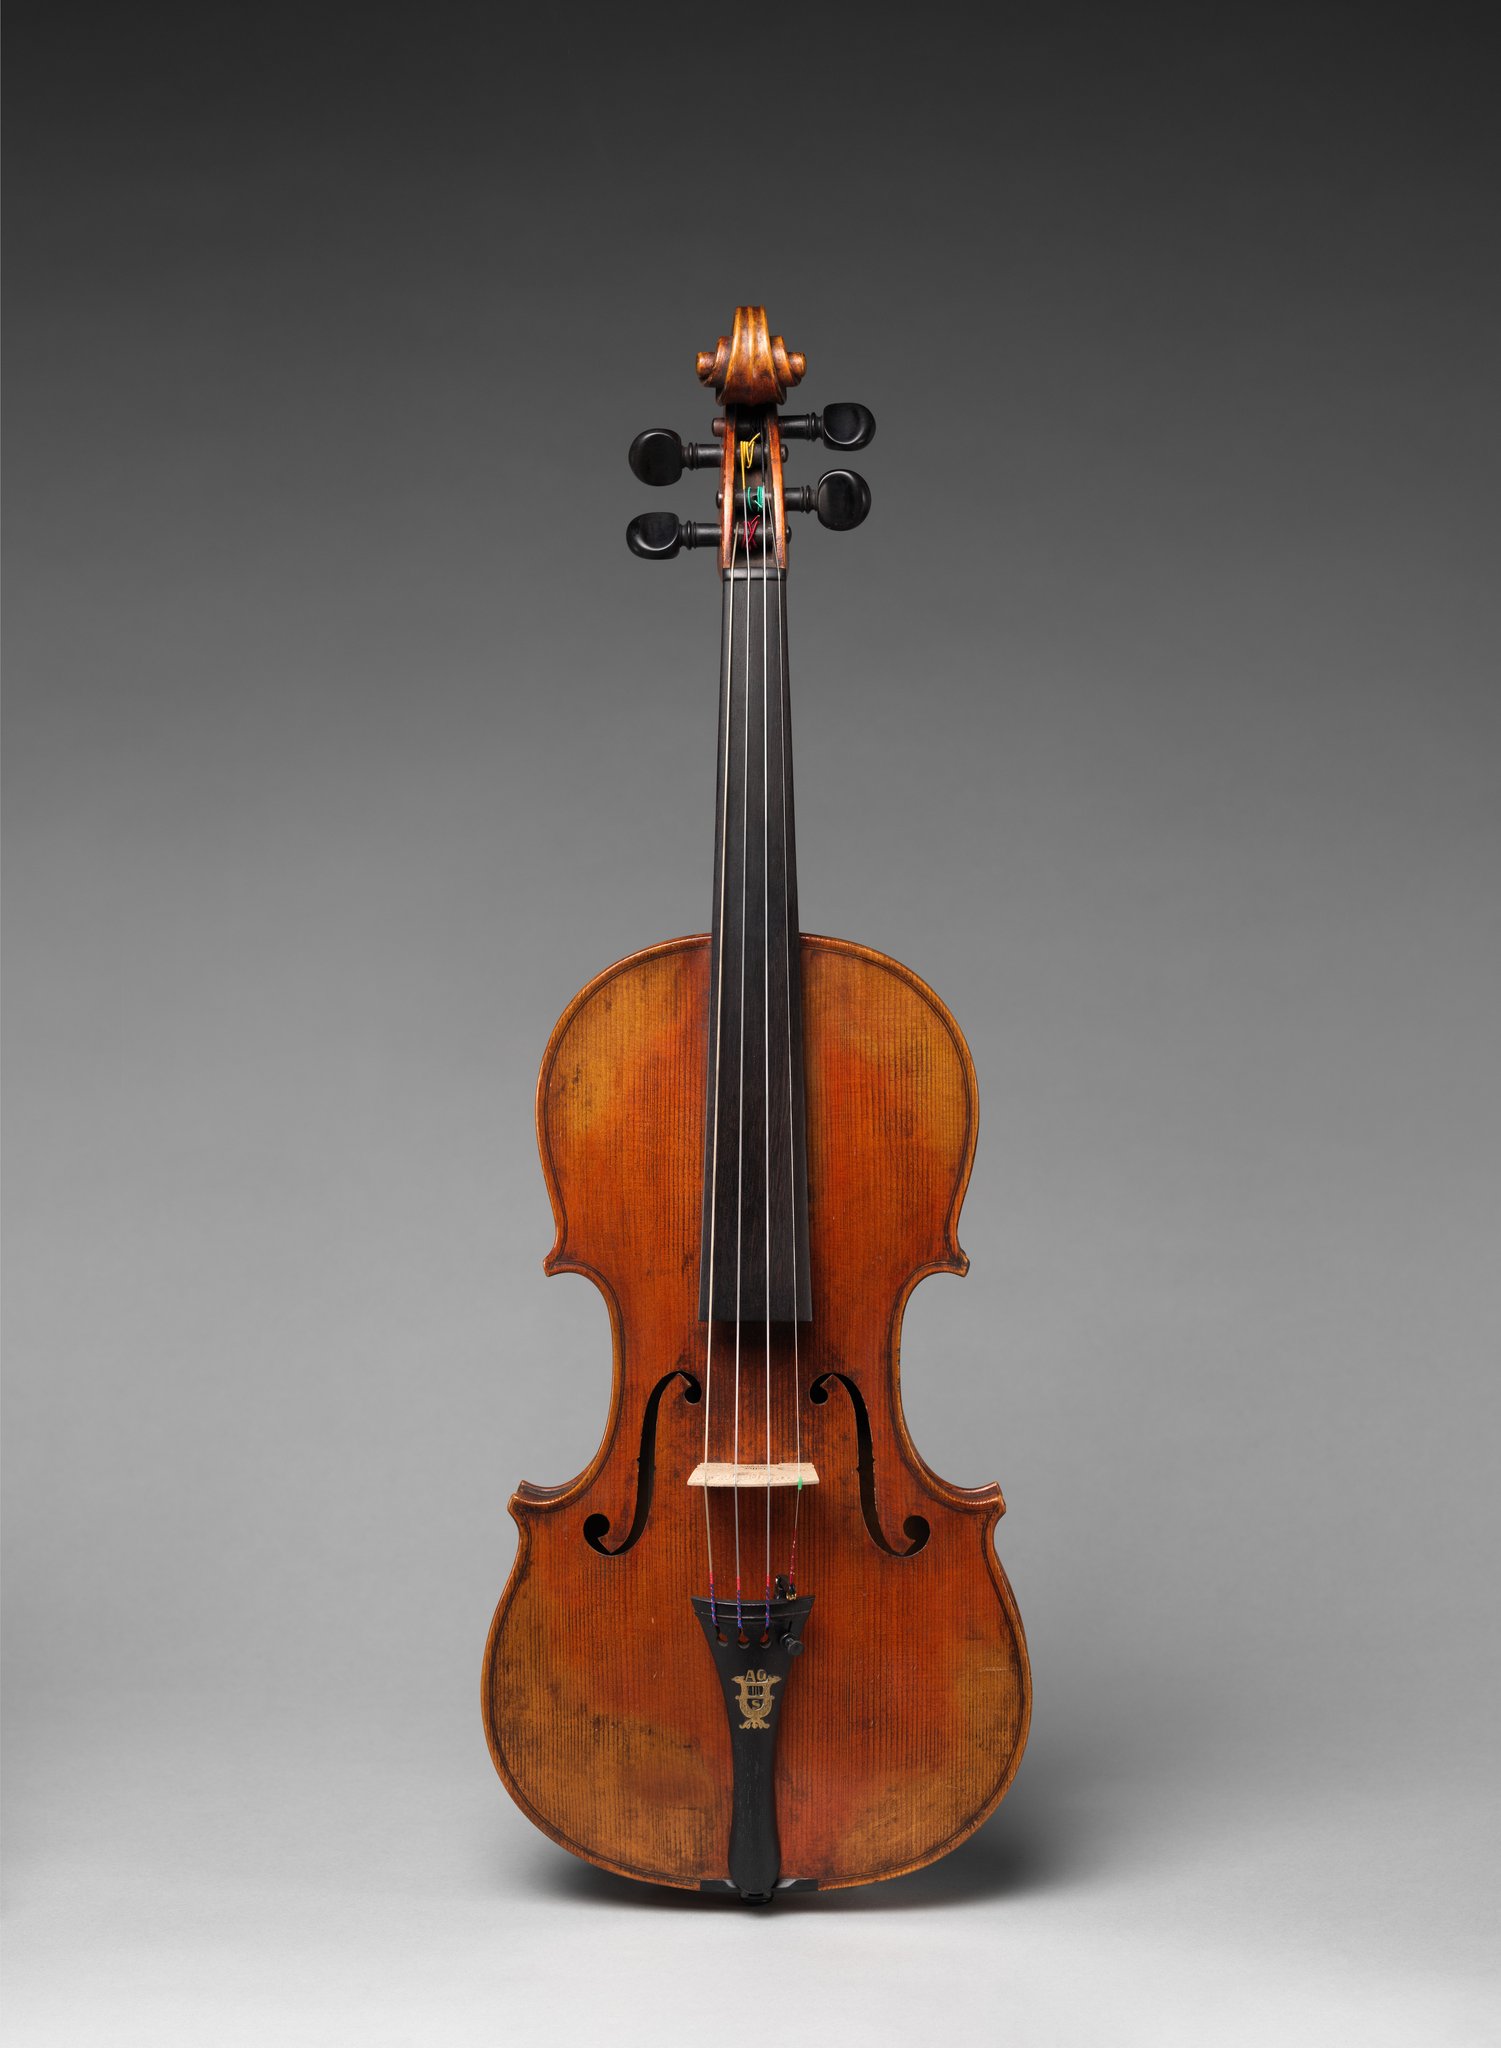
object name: violin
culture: american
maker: august martin gemünder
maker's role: artist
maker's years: 1862-1928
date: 1893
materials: wood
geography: united states